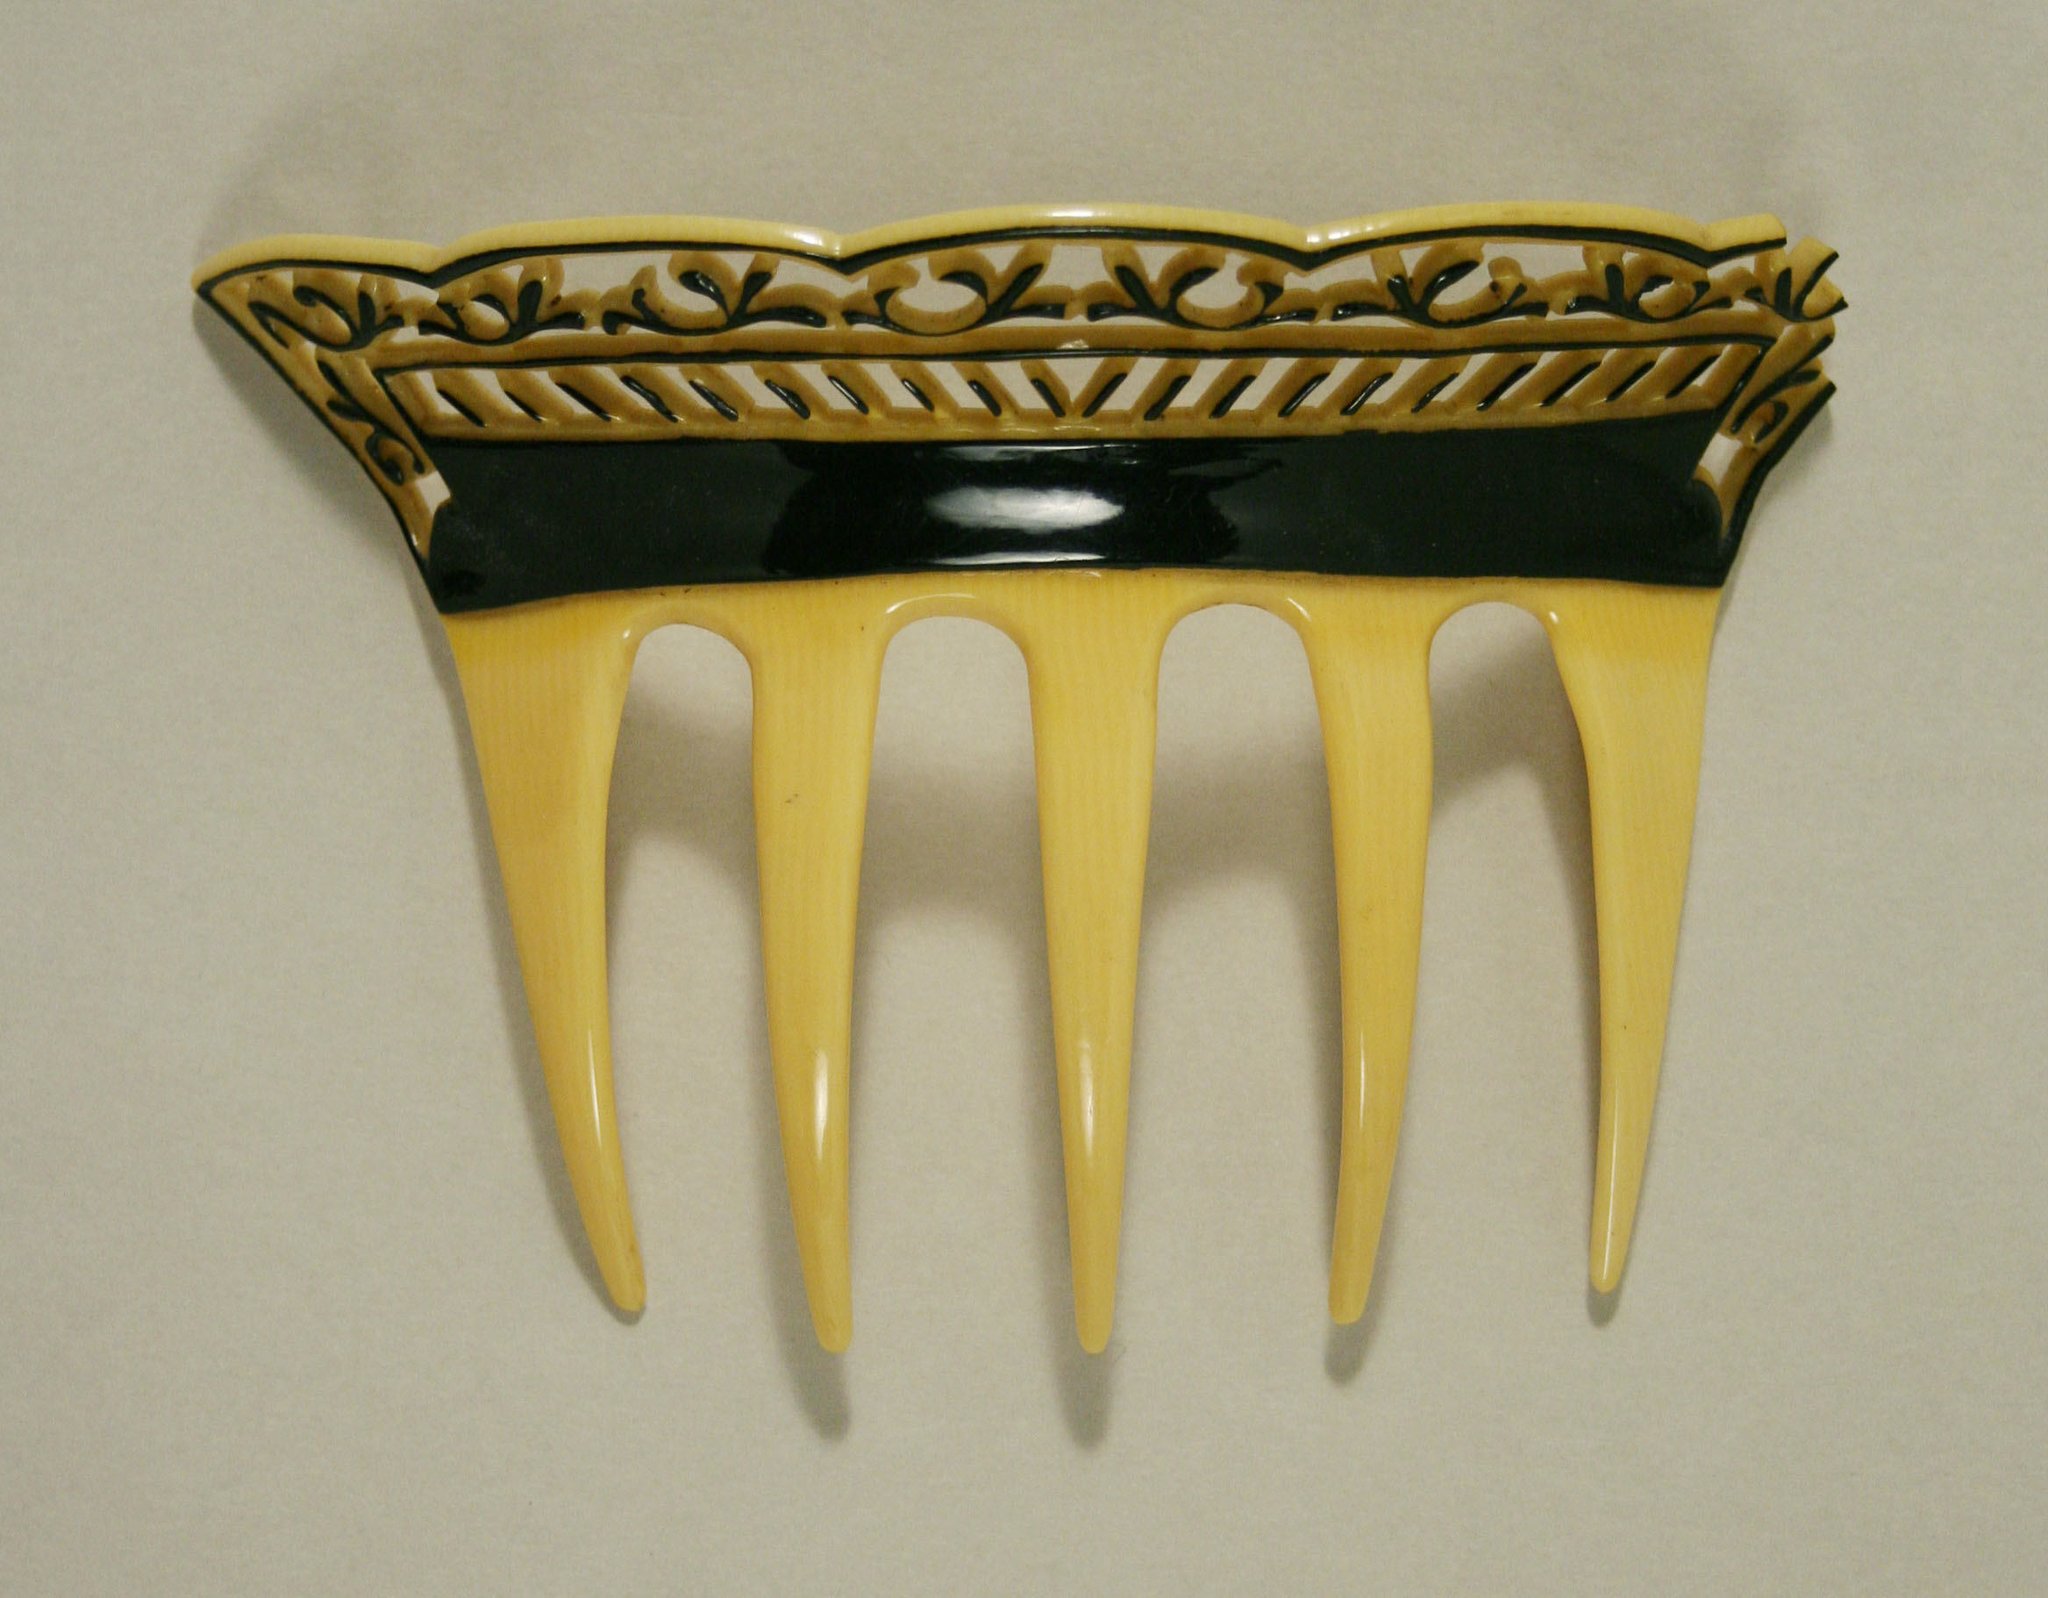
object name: comb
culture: american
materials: plastic